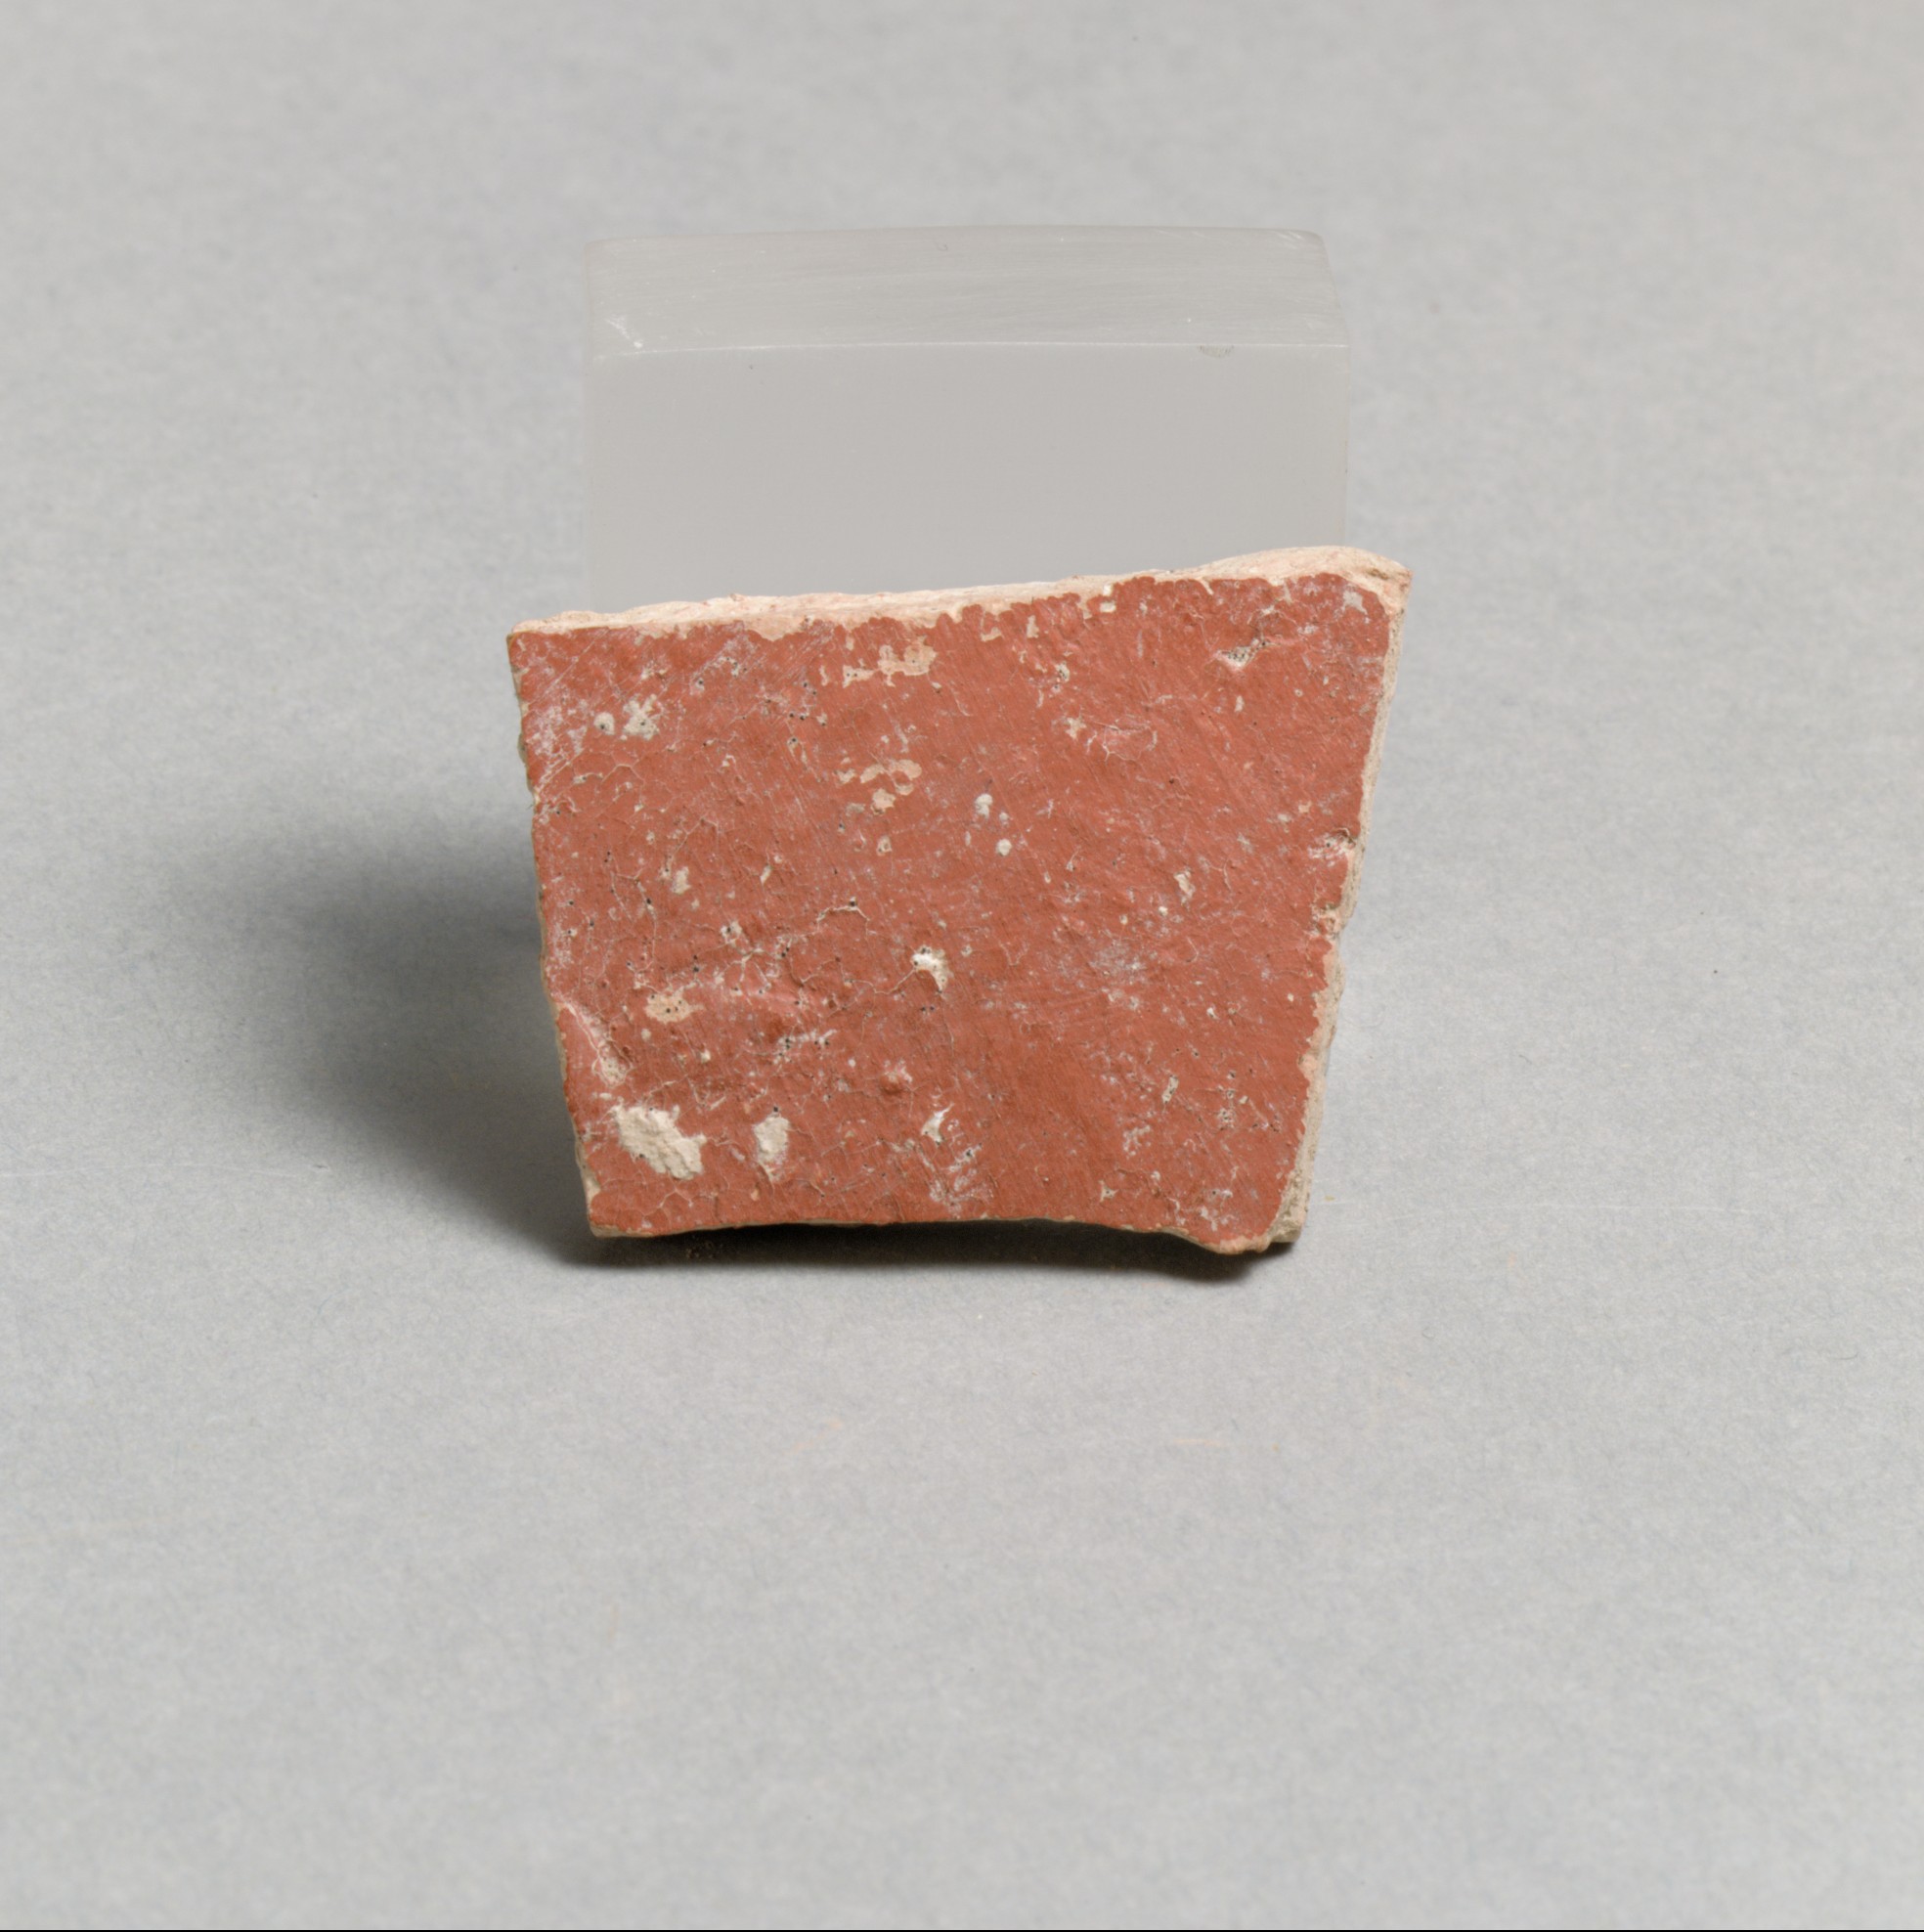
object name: vase fragment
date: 3000-2200 BCE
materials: terracotta